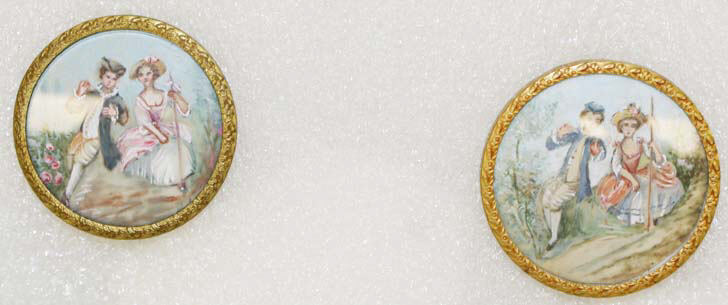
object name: button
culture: french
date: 1860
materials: ivory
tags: men,women